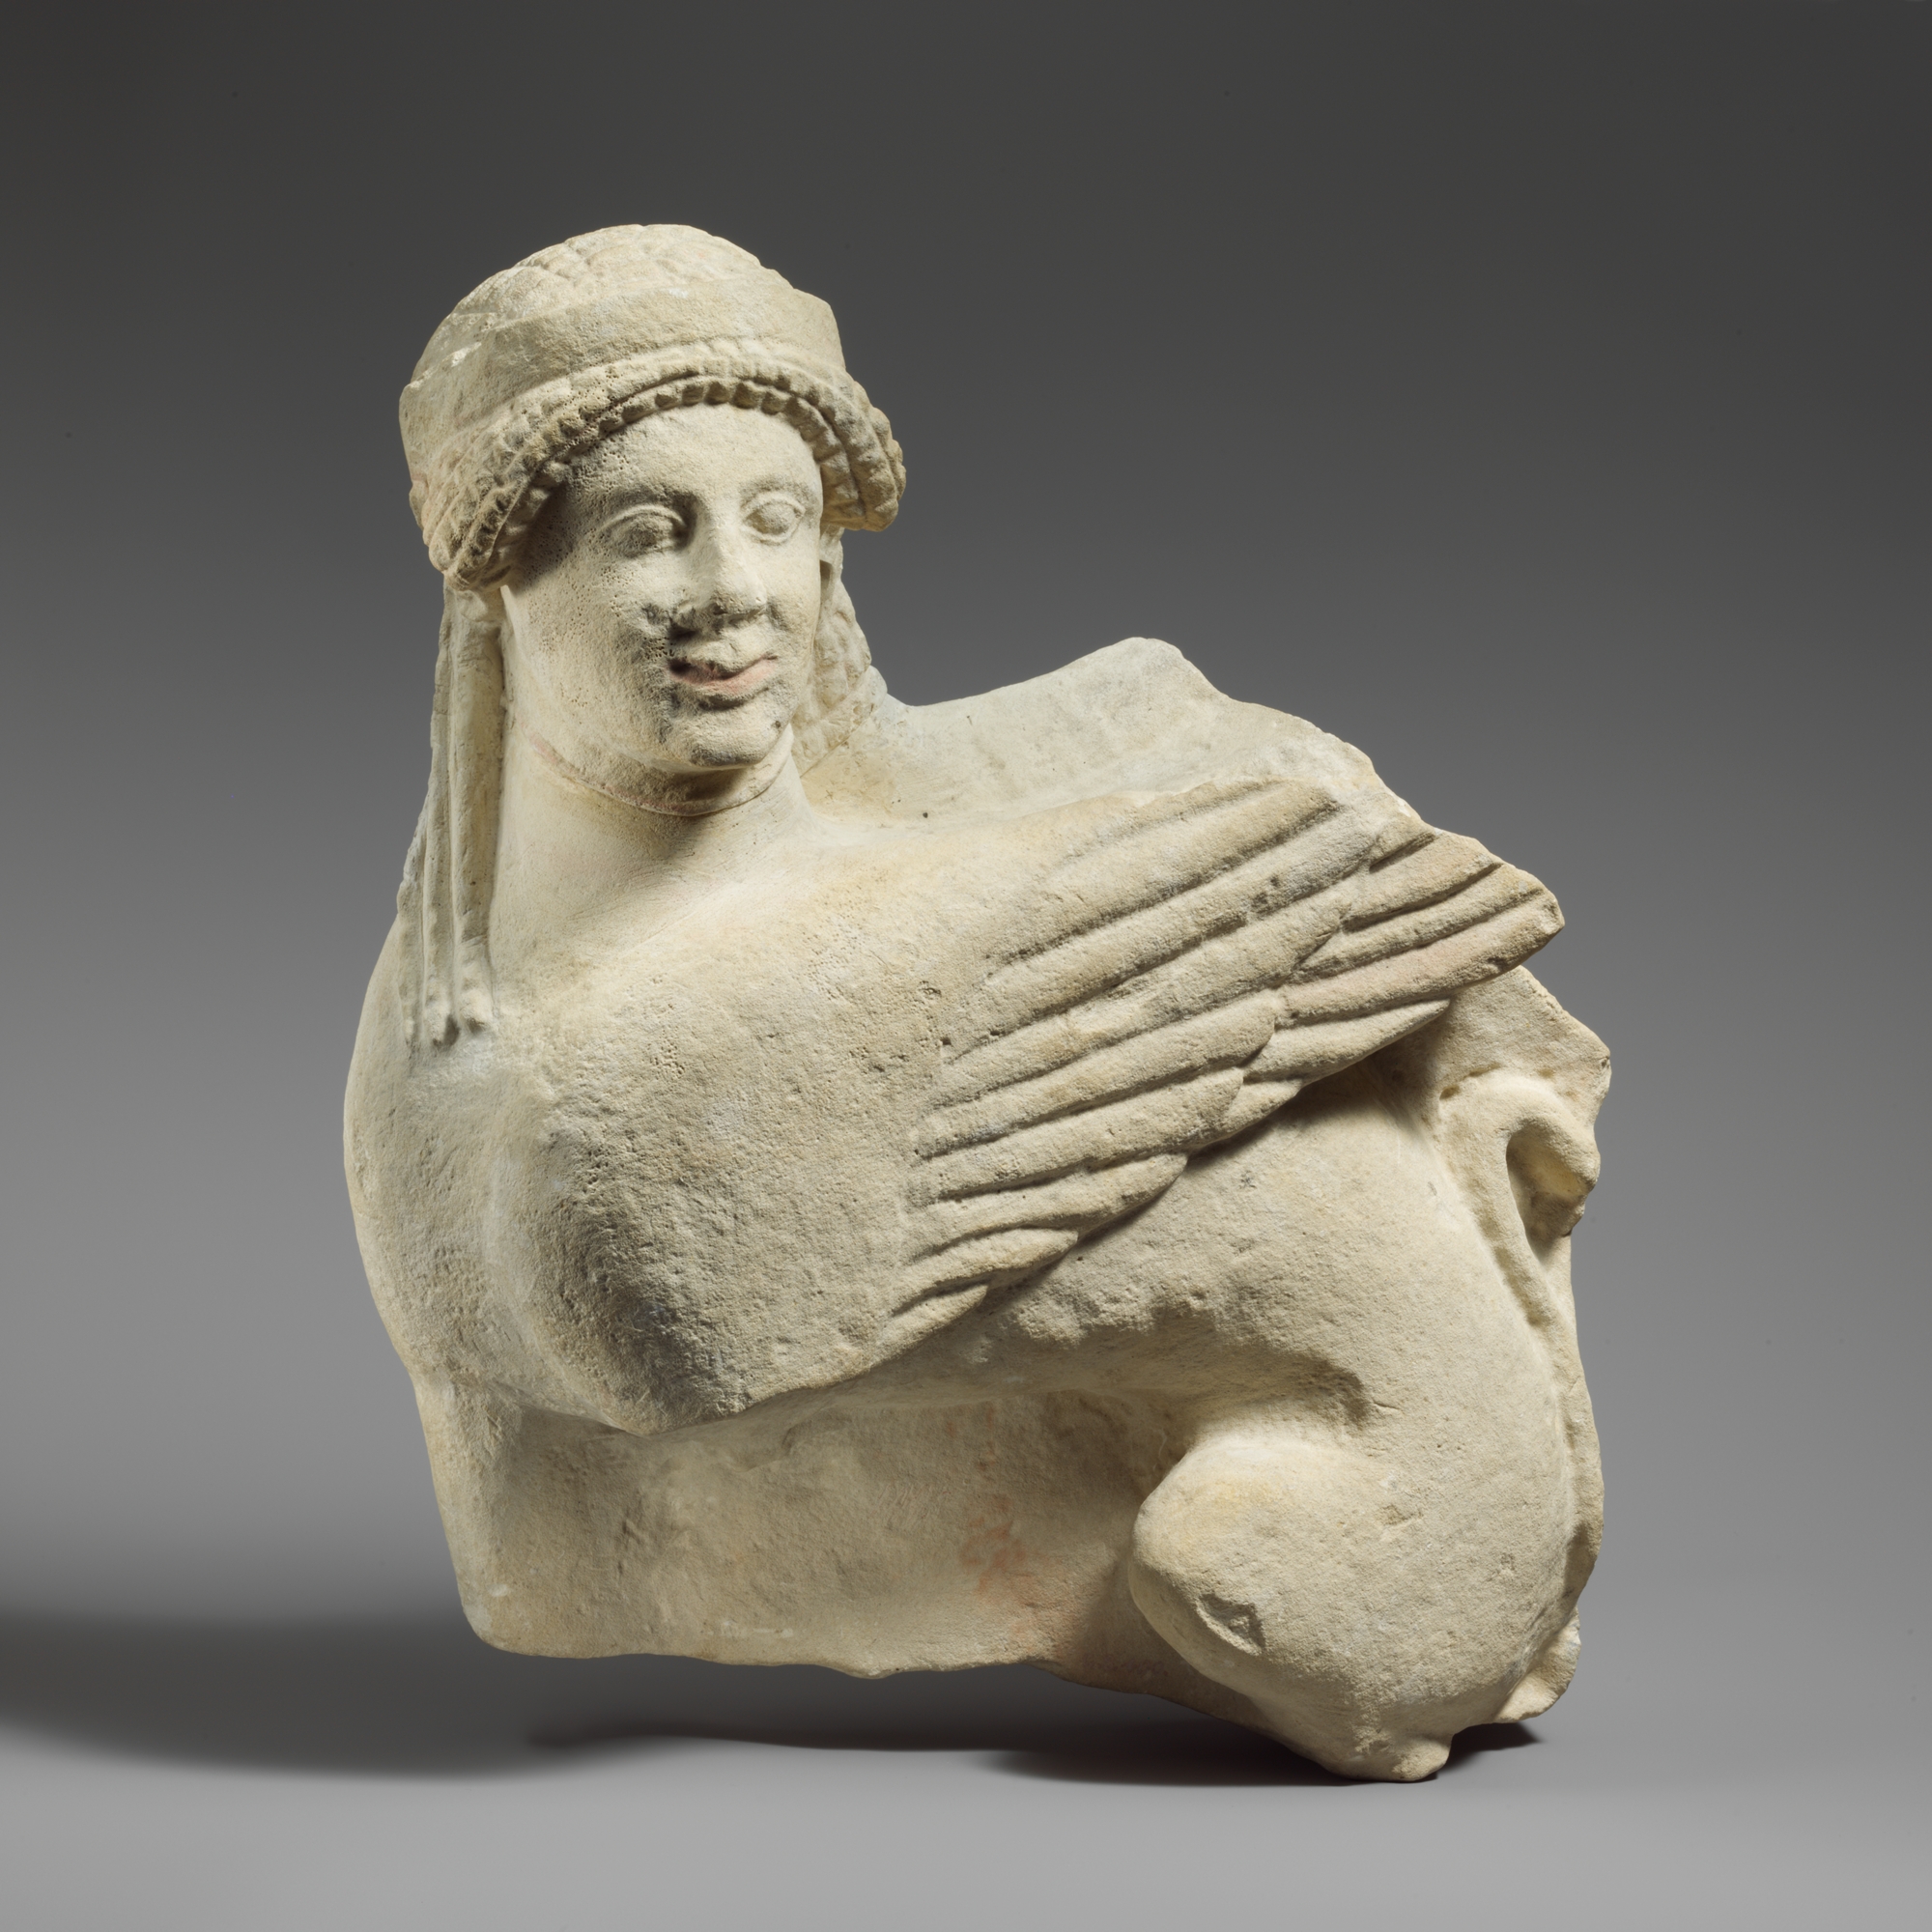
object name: statue of a sphinx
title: Fragment of a limestone funerary stele with a seated sphinx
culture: cypriot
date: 467-435 BCE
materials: limestone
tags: sphinx